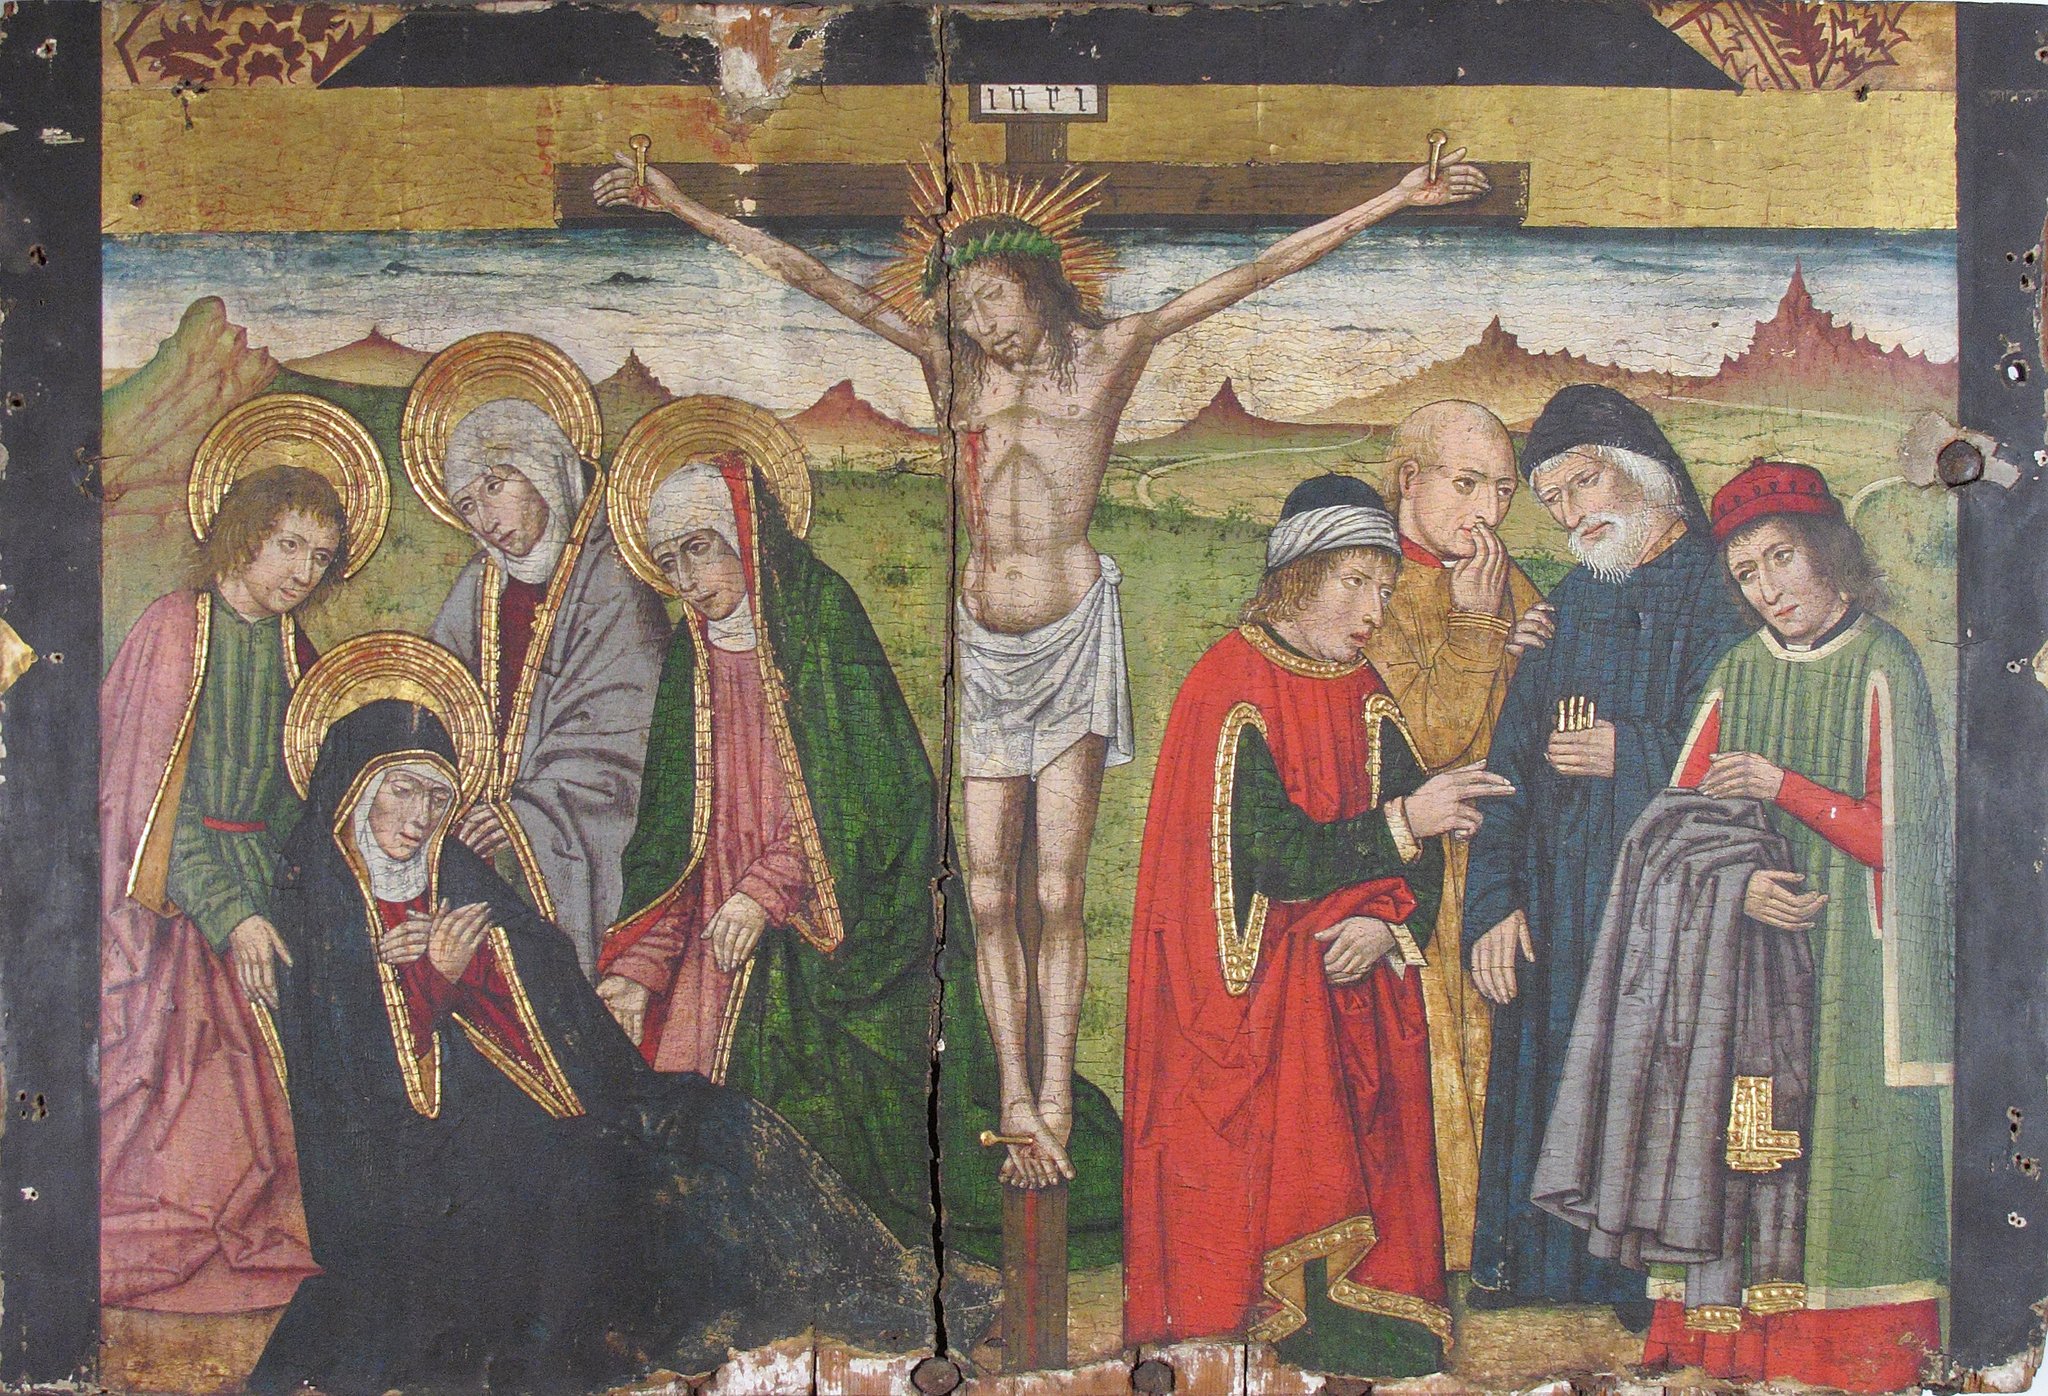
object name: painting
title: Panel with The Crucifixion from Retable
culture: spanish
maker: domingo ram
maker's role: artist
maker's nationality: spanish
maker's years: 1464-1507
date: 1401-1500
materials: gold leaf, paint, wood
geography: spain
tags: christ,virgin mary,crucifixion,saints